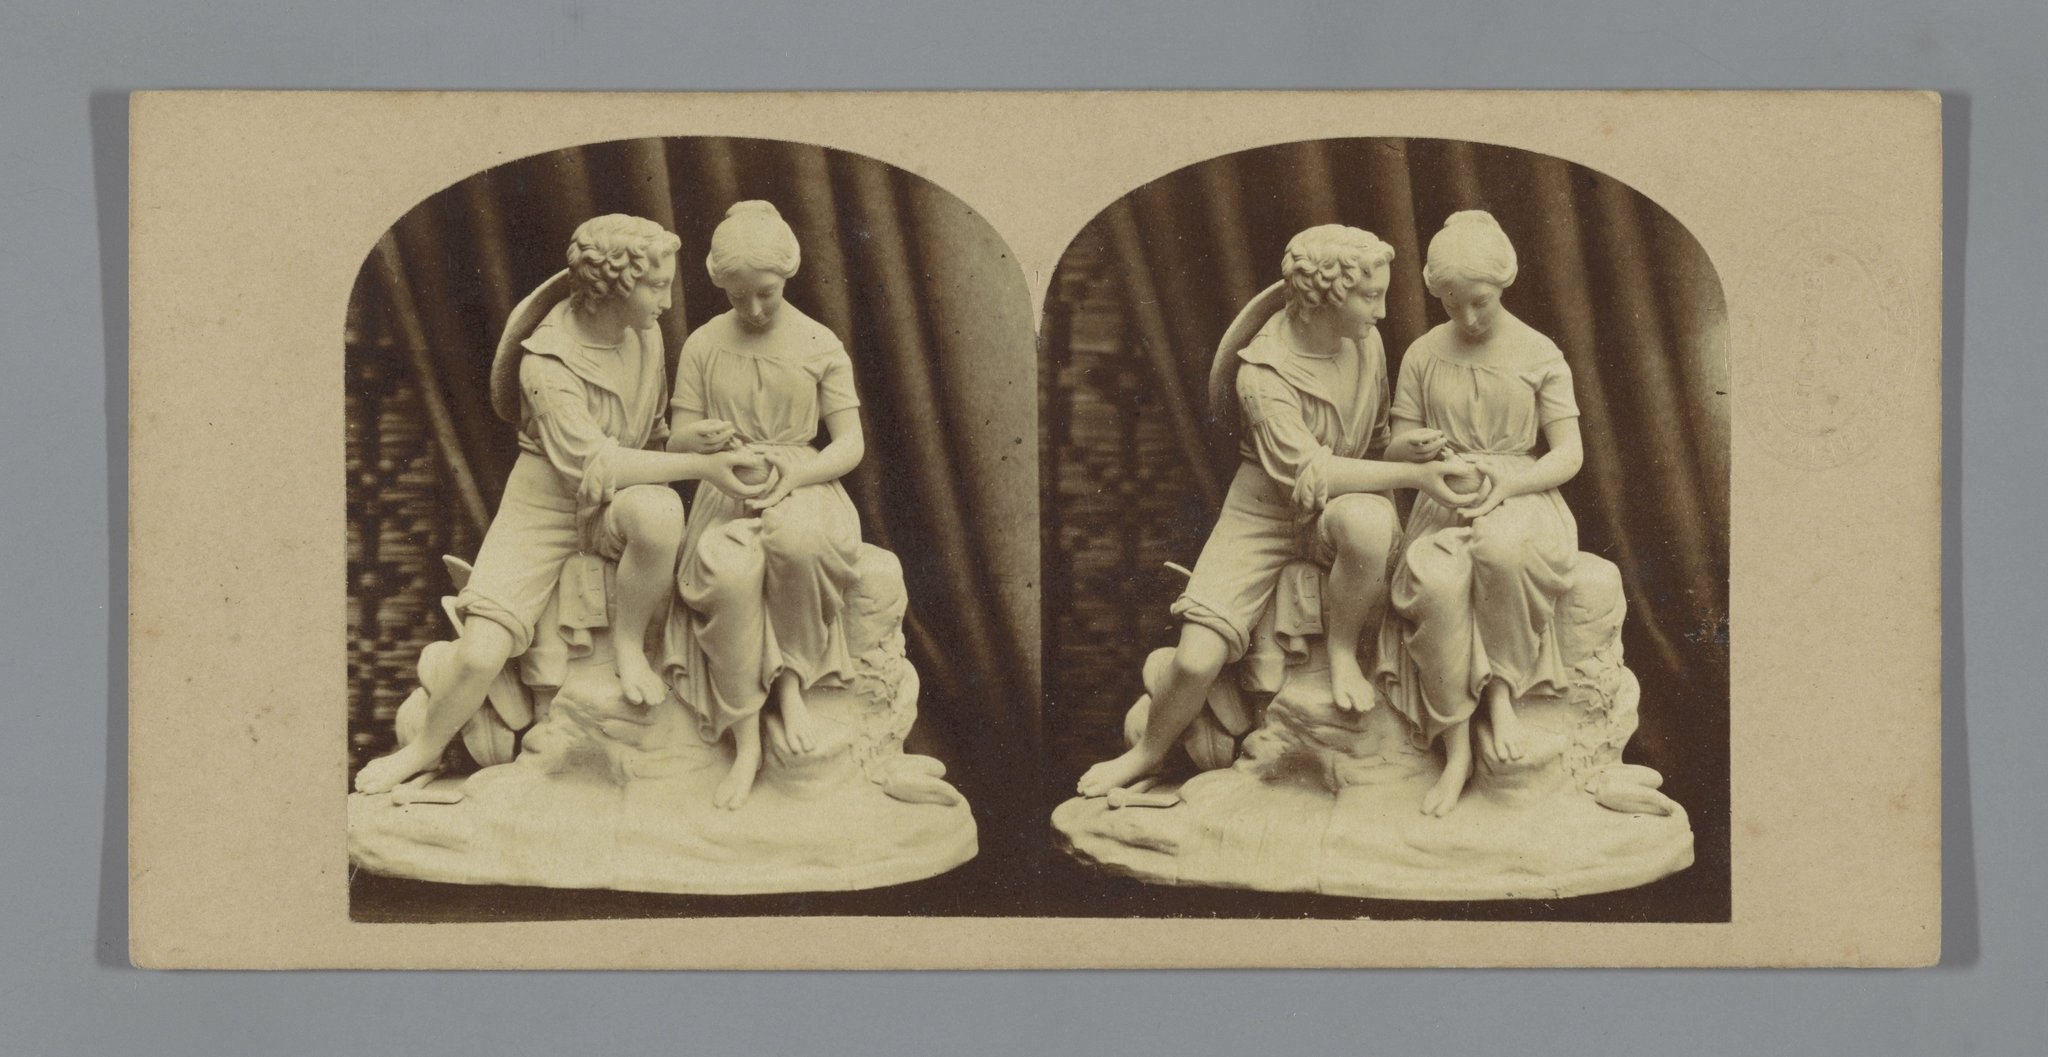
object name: stereograph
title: Paul en Virginia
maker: Anonymous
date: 1855-1880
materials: cardboard, photographic support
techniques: albumen print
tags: sculpture, couple of lovers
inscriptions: check stamp: ‘Cheapside 54’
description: Twee hoofdfiguren uit het boek Paul and Virginia van Jacques-Henri Bernardin de Saint-Pierre.